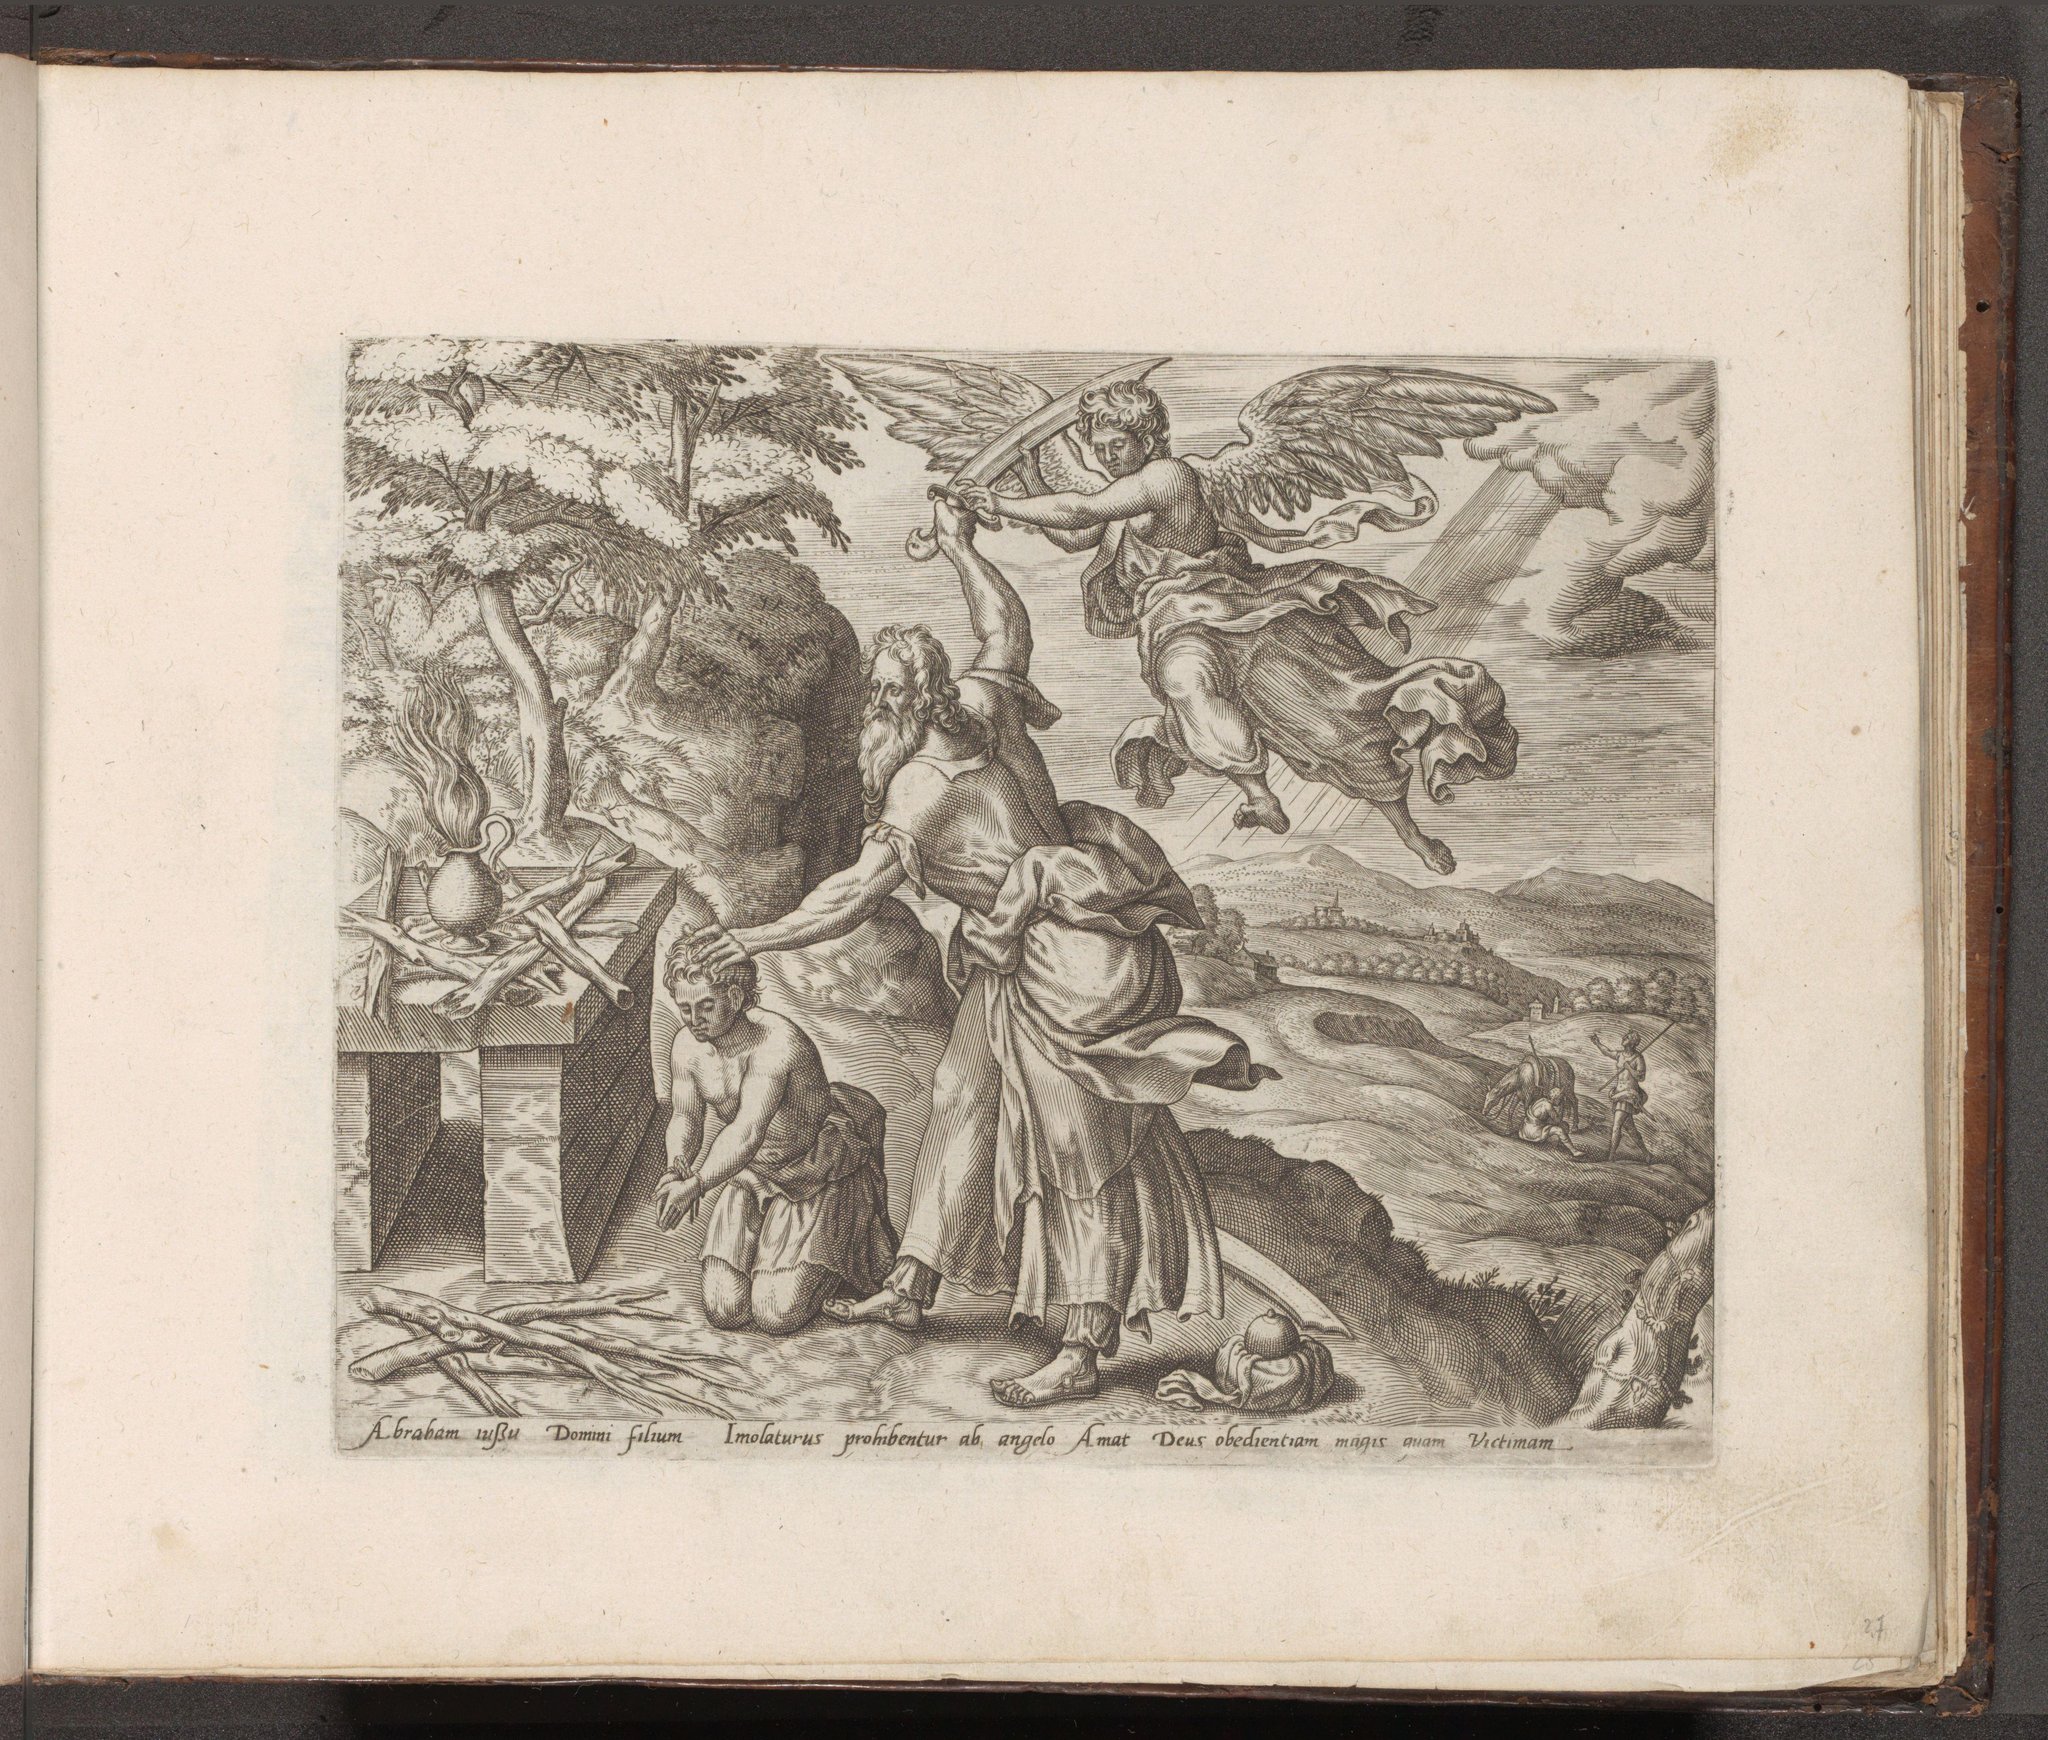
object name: album leaf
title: Geschiedenis van Abraham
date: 1579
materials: paper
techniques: engraving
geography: antwerp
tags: when abraham has his hand raised to kill isaac, an angel restrains abraham's hand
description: Abraham heft zijn zwaard om zijn zoon Isaak te offeren, maar een engel weerhoudt hem daarvan. Links zit een ram in de struiken verstrikt, die in Isaaks plaats zal worden geofferd. Rechts in het landschap de achtergelaten ezel en de knechten. Onder de voorstelling een verklarende tekst in het Latijn. Prent maakt deel uit van een album.